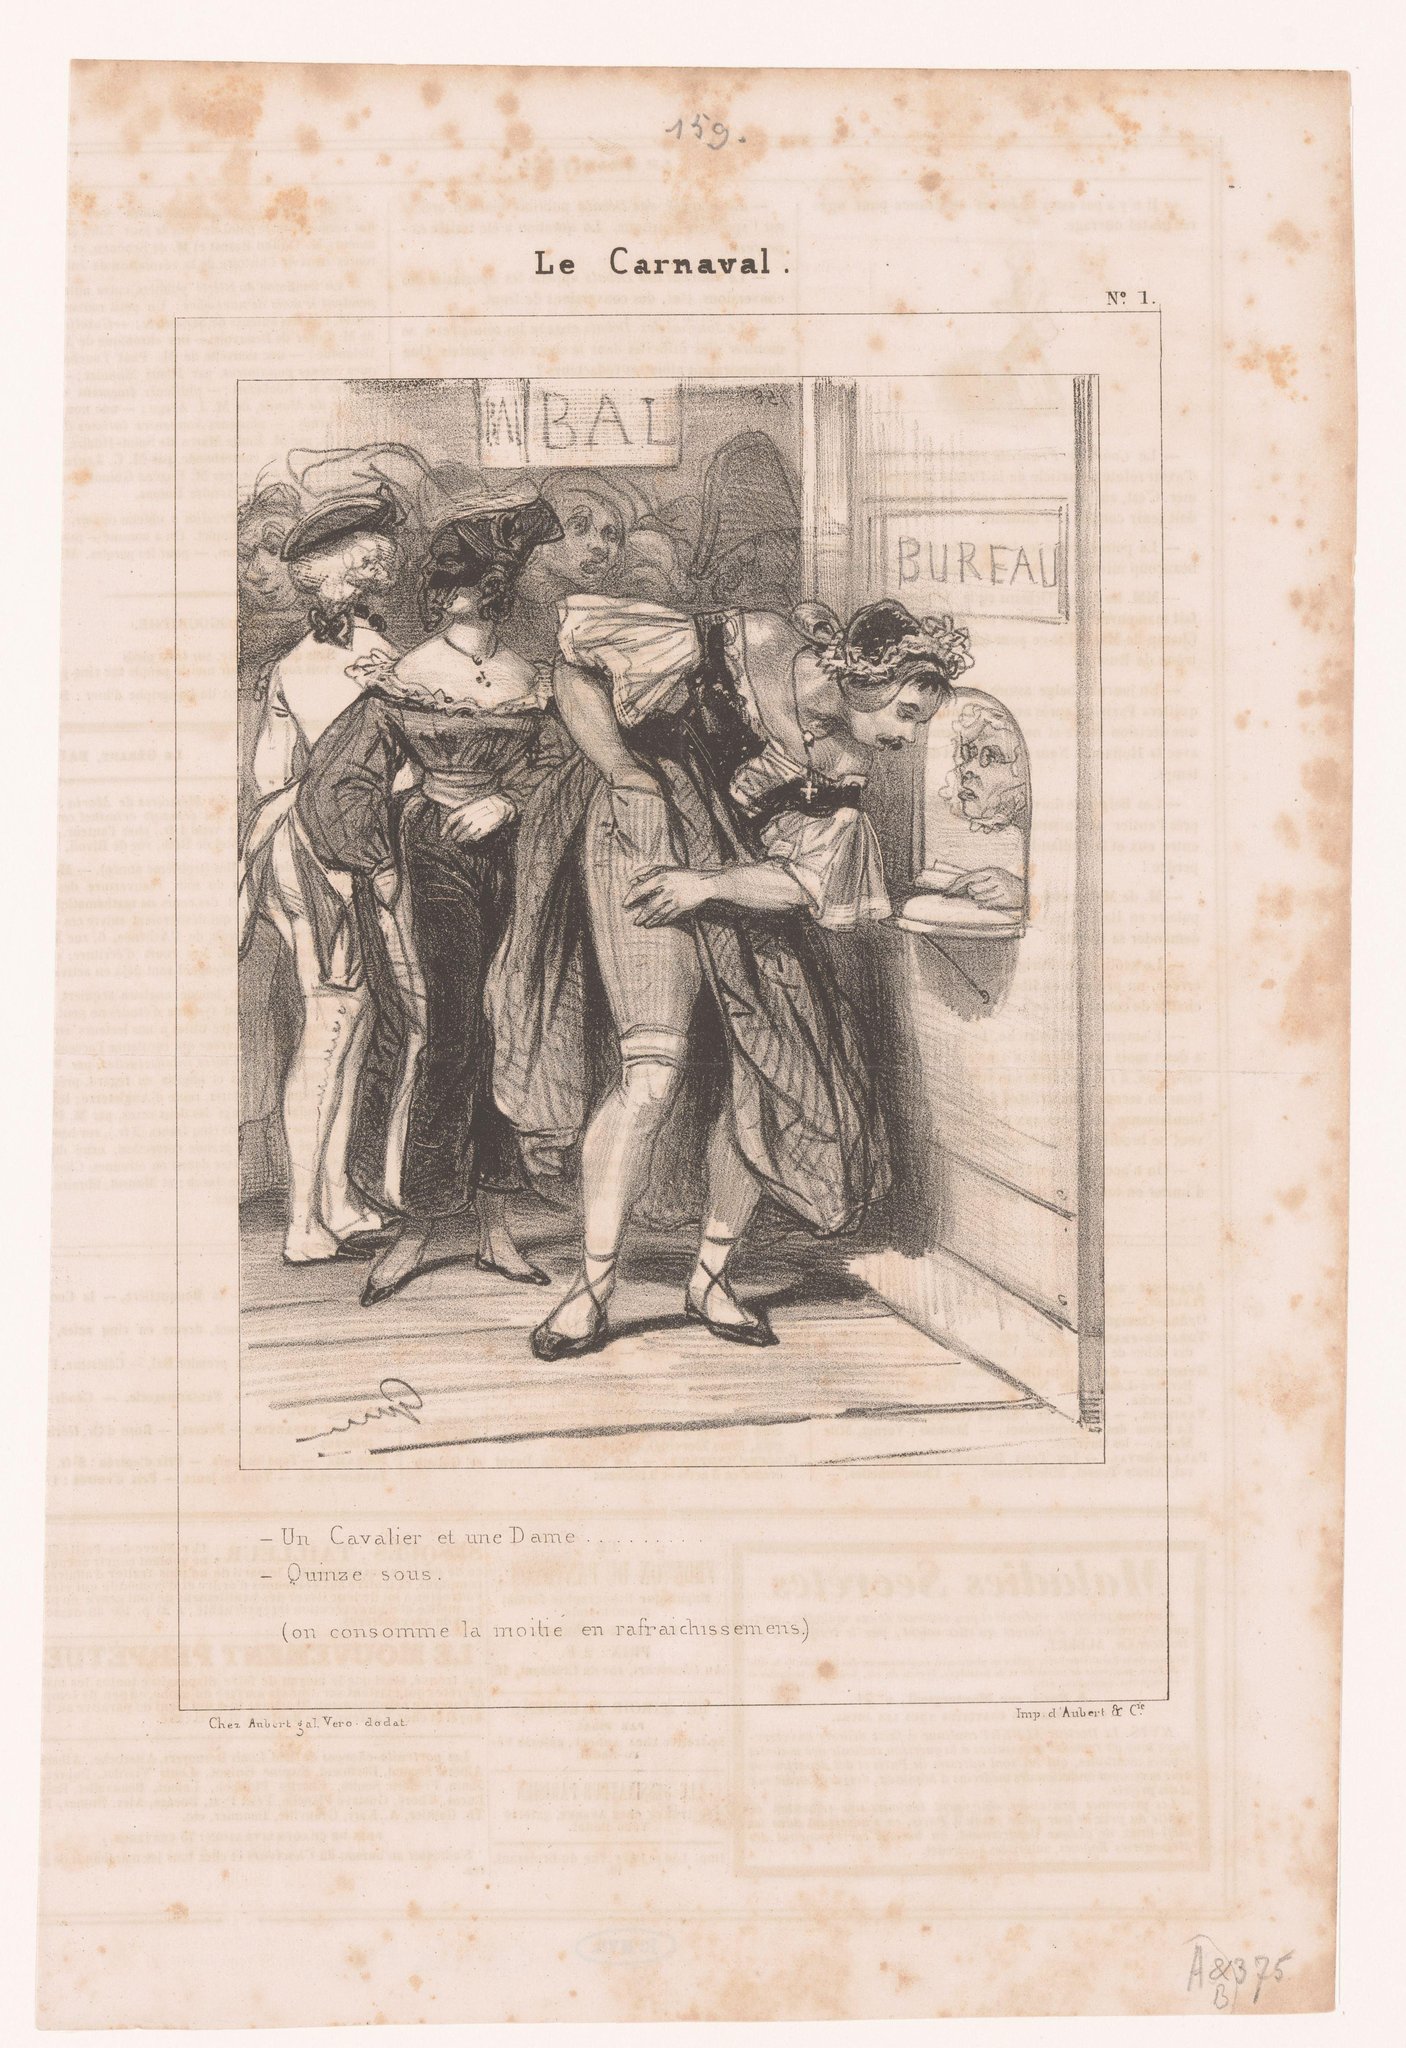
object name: print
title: Carnaval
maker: paul gavarni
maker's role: draughtsman, print maker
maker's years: 1804-1866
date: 1838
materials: paper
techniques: lithograph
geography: paris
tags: man dressed as woman, travesty, masquerade, masked ball, carnival, shrovetide (non-liturgical celebration)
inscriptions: collector's mark: Lugt 2228a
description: Een als vrouw verklede man heeft zijn rok omhoog gedaan om munten uit zijn broekzak te kunnen halen. Hij staat voor het loket van een etablissement waar een gemaskerd bal wordt gehouden.